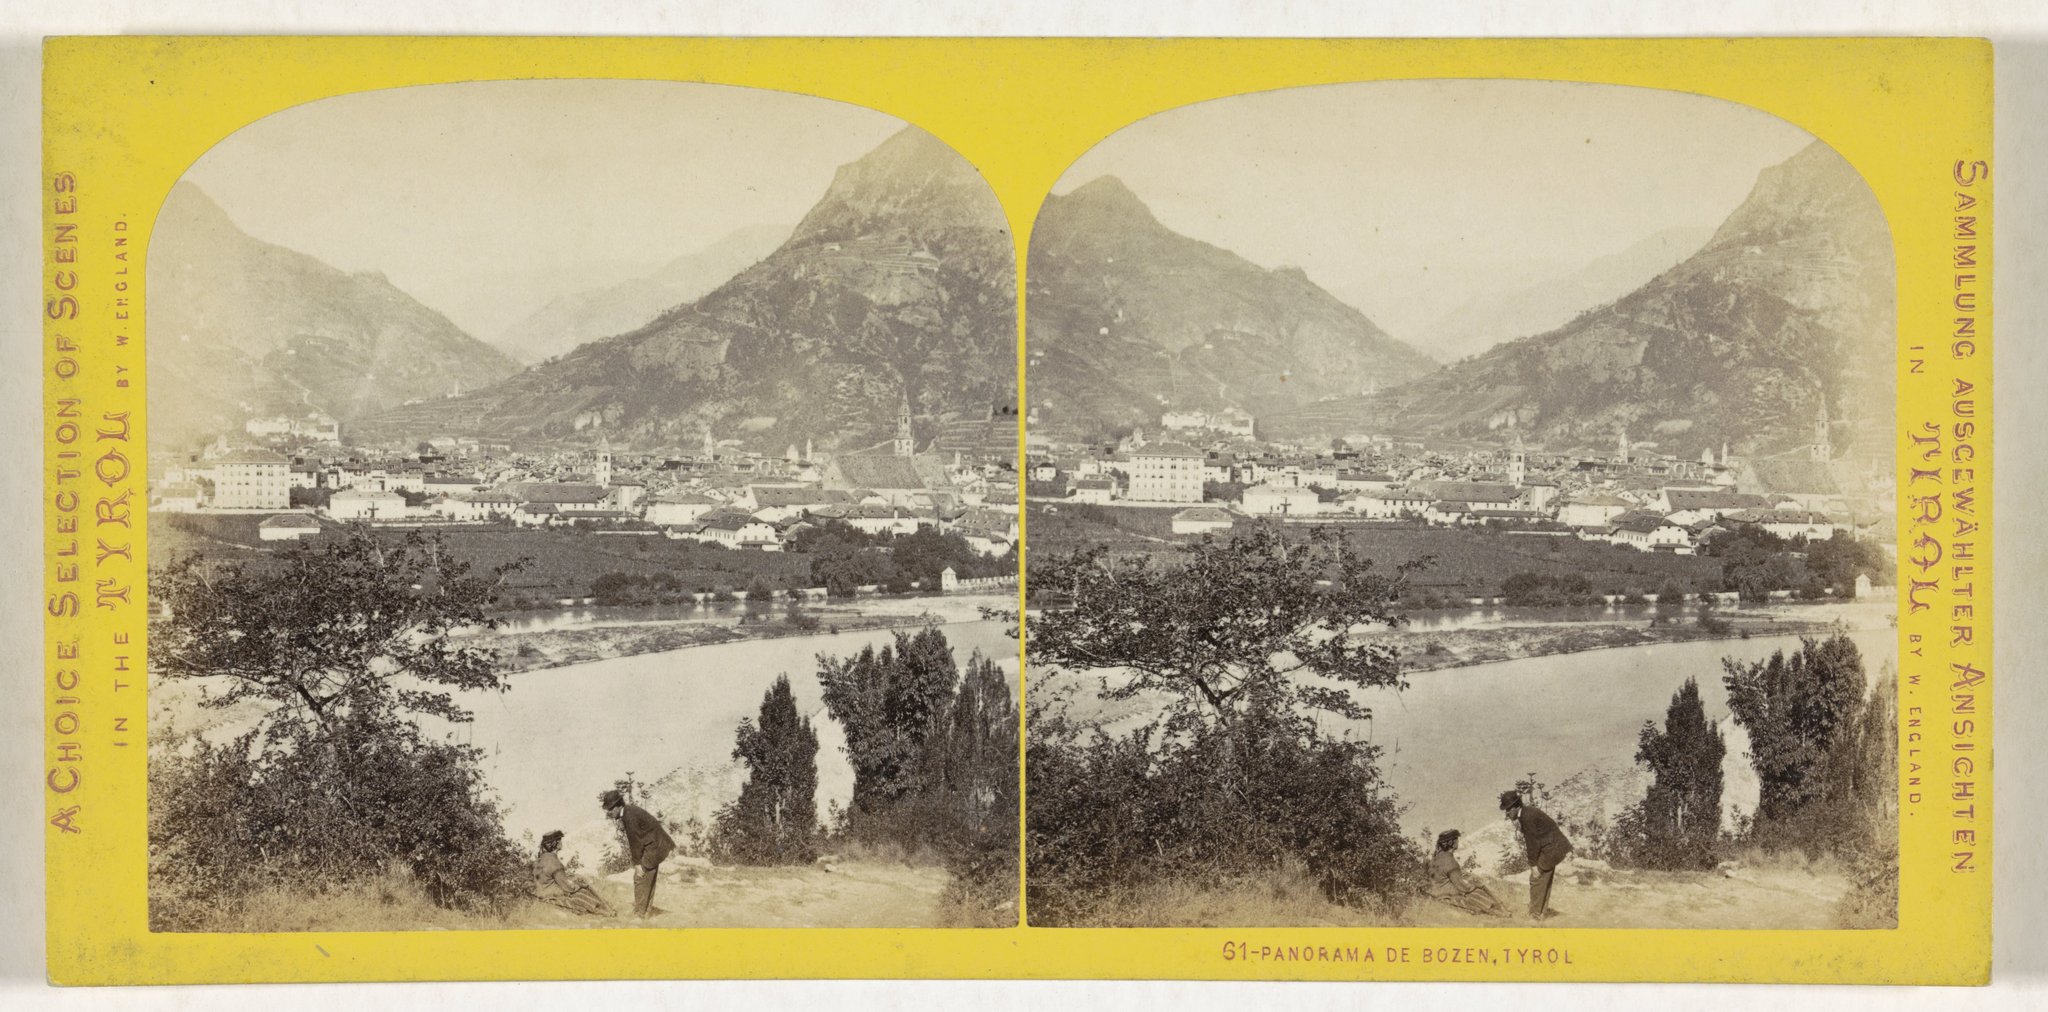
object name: stereograph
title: Panorama de Bozen, Tyrol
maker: william england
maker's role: fotograaf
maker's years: 1816-1896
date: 1863-1865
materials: cardboard, paper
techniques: albumen print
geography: bolzano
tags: city-view in general; 'veduta'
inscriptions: number: ‘61’